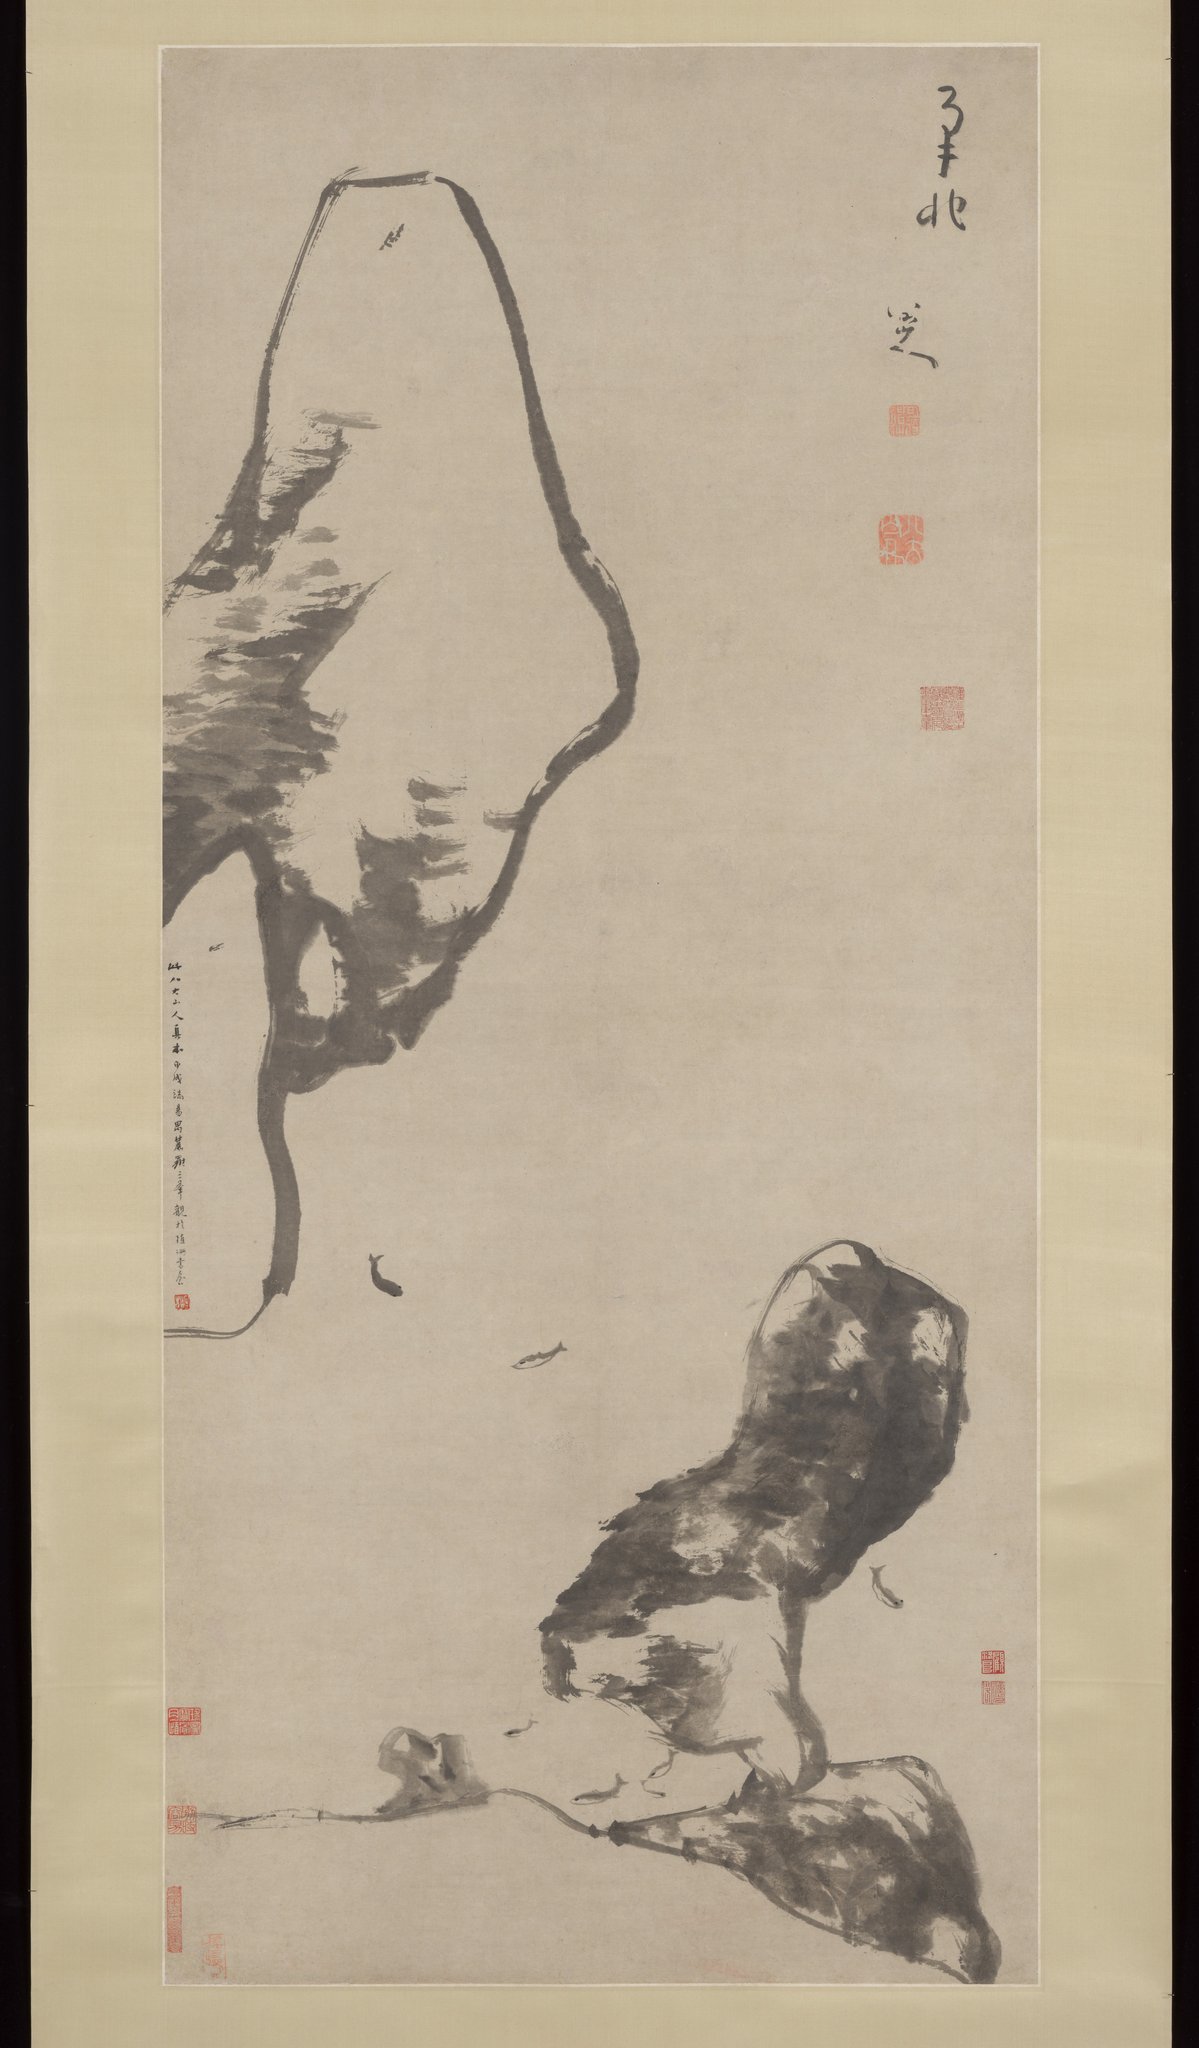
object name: hanging scroll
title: Fish and rocks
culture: chinese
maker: bada shanren (zhu da)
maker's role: artist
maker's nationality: chinese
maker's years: 1626-1705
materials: ink, paper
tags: fish